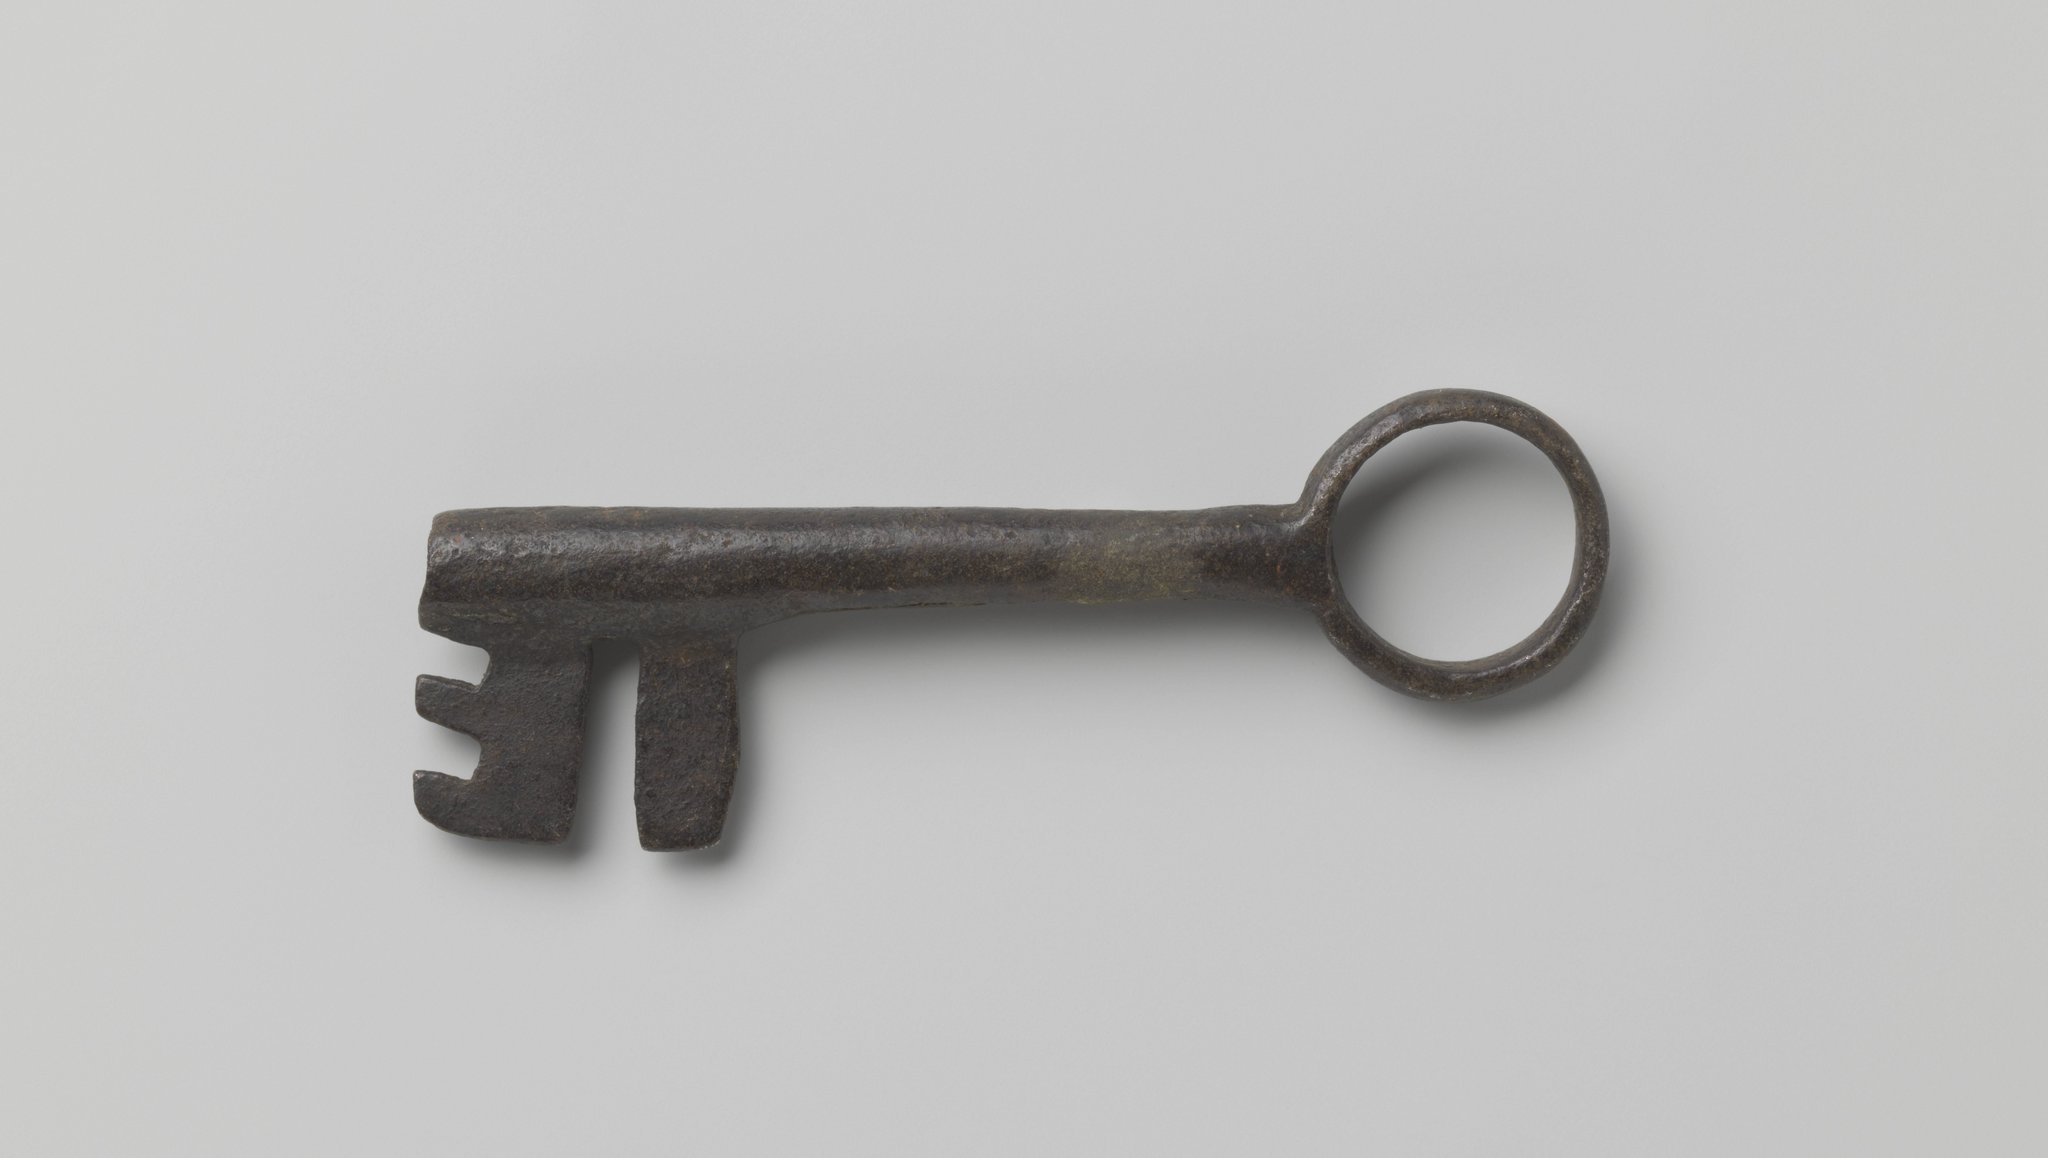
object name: pipe key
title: Pijpsleutel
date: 1000-1300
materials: iron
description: Pijpsleutel uit een stuk gesmeed met ringvormig oog en tweedelige baard.